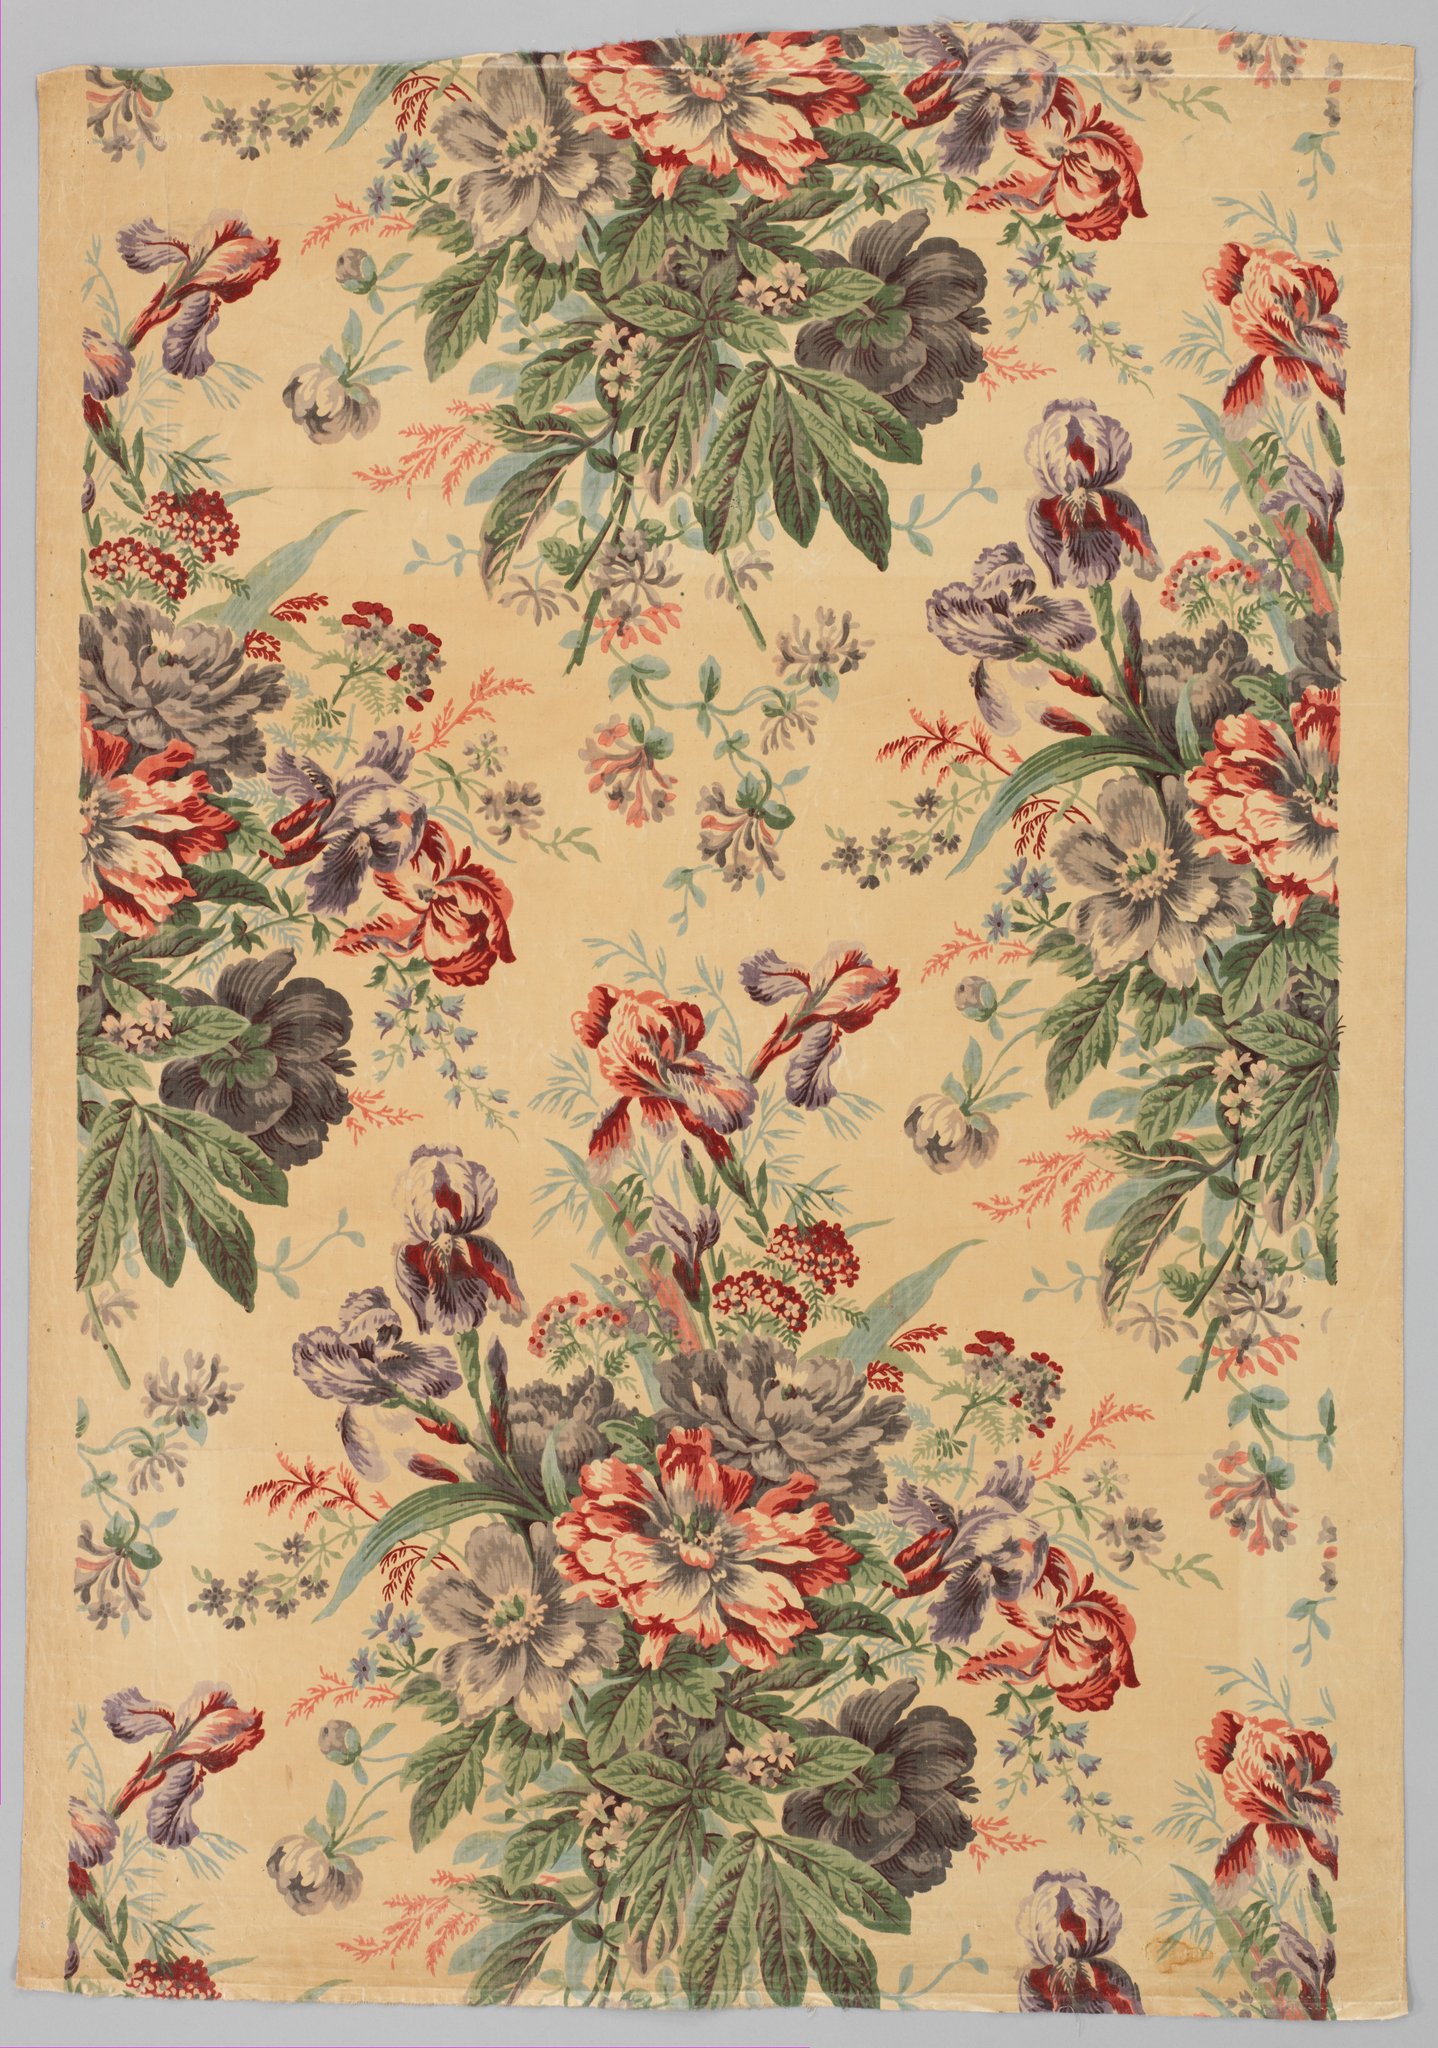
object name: piece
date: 1801-1900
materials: cotton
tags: flowers